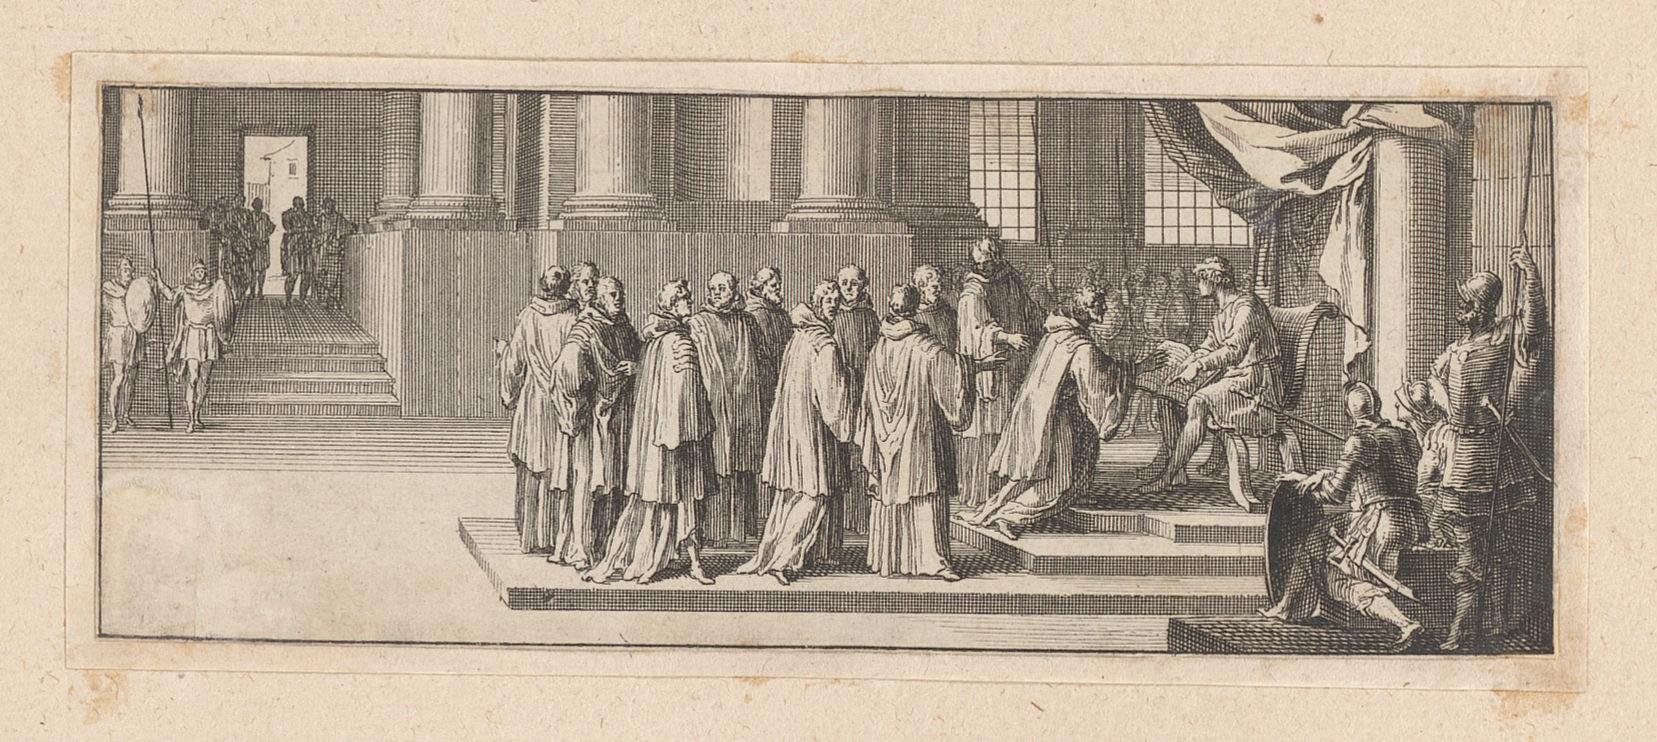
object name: print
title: Vignet met Guillaume Cohardon die het land aan de koning overdraagt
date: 1687-1701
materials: paper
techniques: engraving, etching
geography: toulouse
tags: historical persons, vignette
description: Prent gebruikt voor: La Faille, Germain de. Annales de la ville de Toulouse depuis la réunion de la Comté de Toulouse à la couronne (...). Toulouse: Guillaume-Louis Colomyez en Jérôme Posuel, 1687-1701. Vignet voor: Divers titres et actes (...).